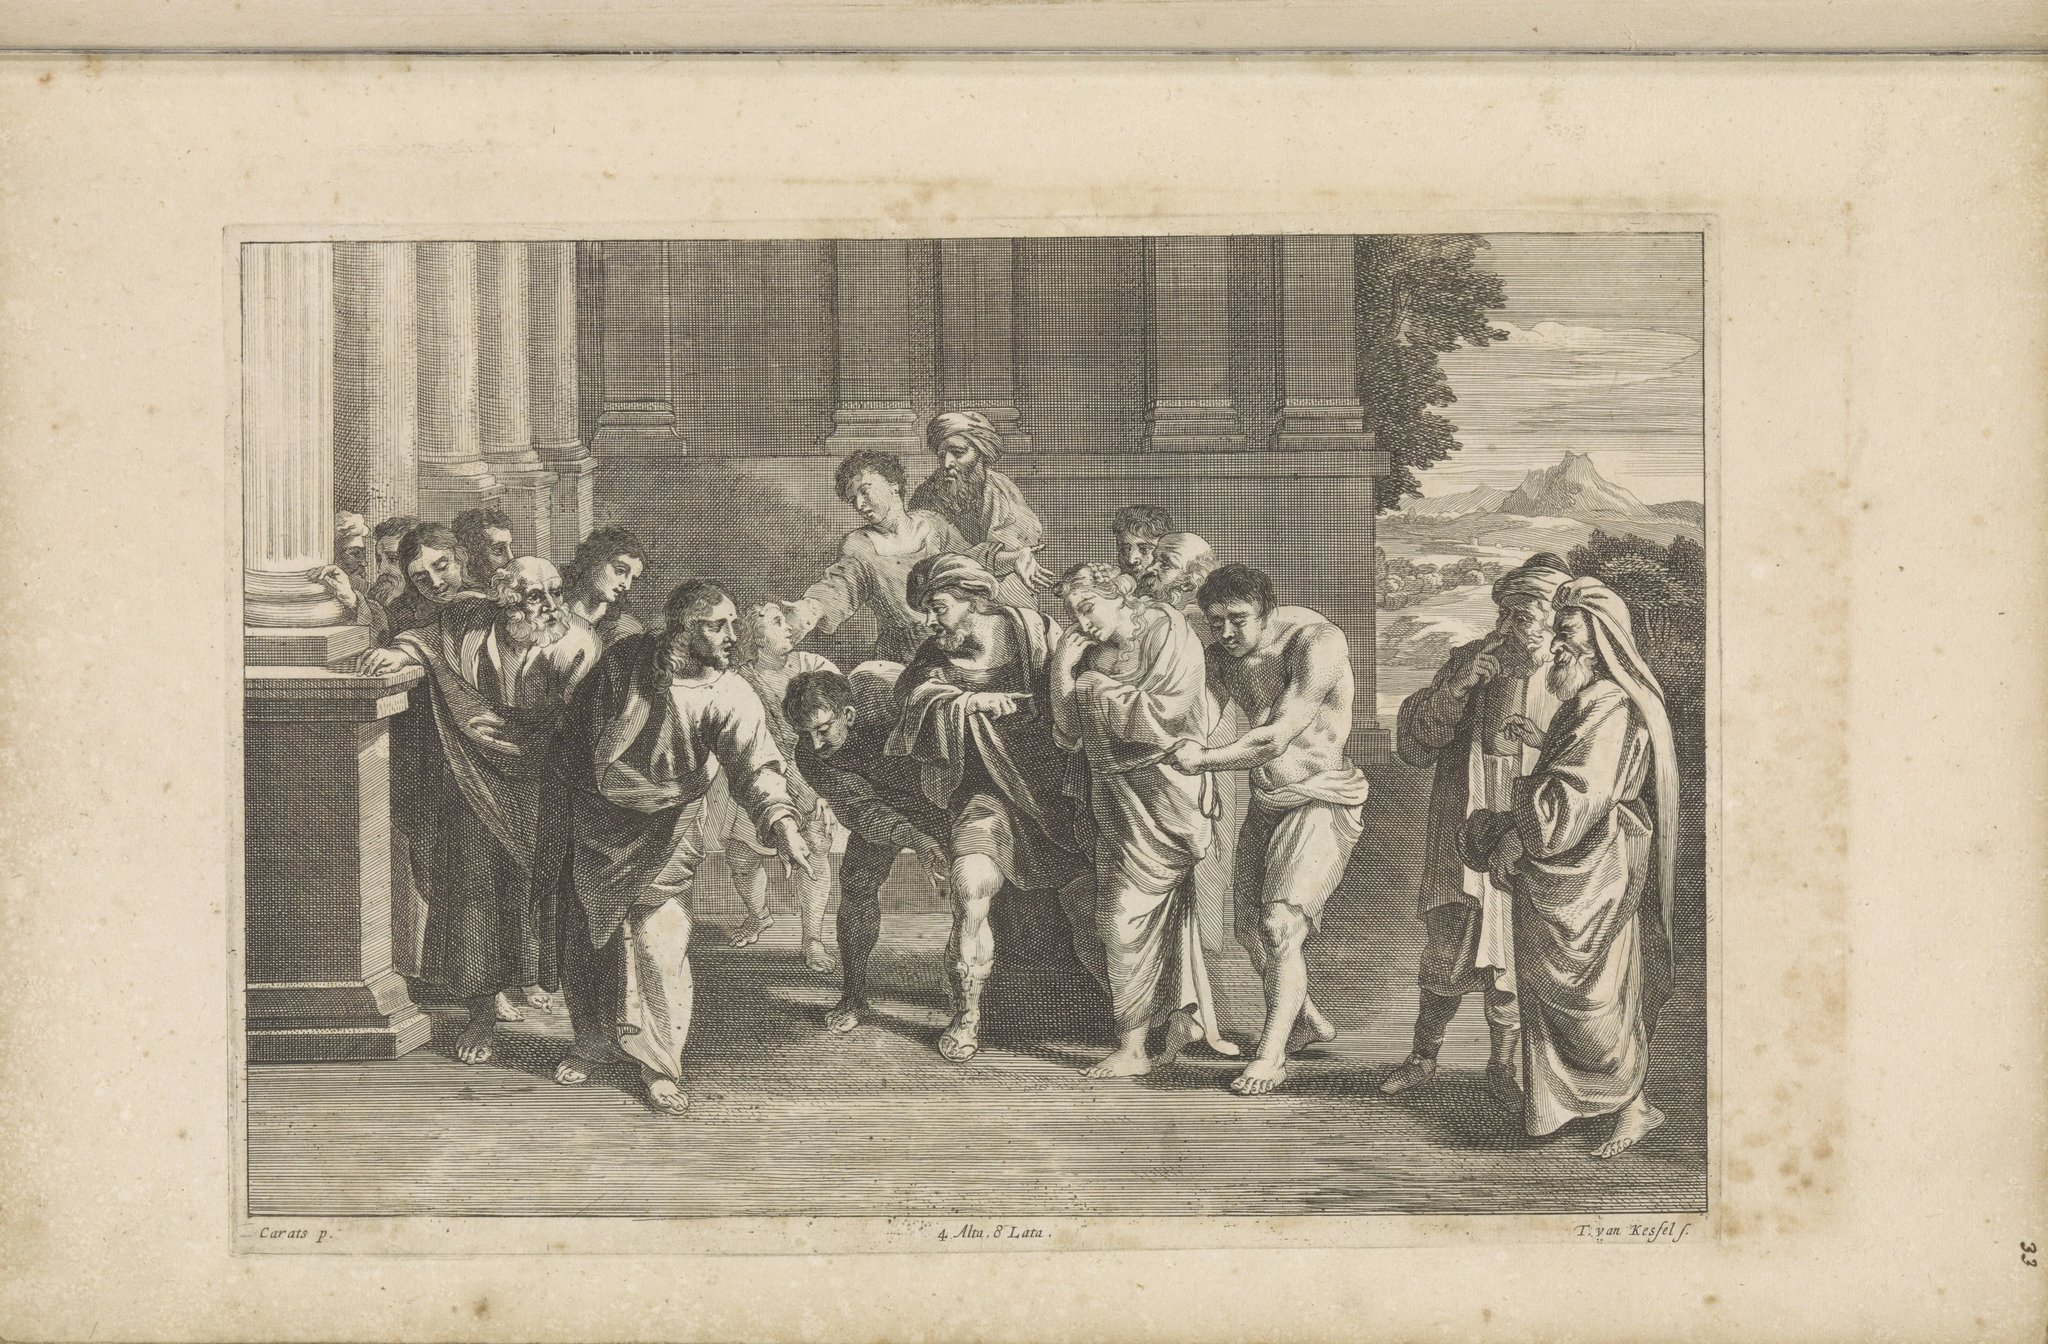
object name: print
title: Christus en de overspelige vrouw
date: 1660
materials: paper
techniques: engraving, etching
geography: antwerp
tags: christ points to or writes on the ground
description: David Teniers heeft waarschijnlijk van alle schilderijen uit de collectie van Leopold Willem van Oostenrijk een olieverfstudie op doek of paneel vervaardigd (zgn. pasticcio), die als voorbeeld voor de prentmakers diende. Het is niet altijd duidelijk of de pasticci door hem zijn gemaakt of door zijn atelier. Niet alle pasticci zijn overgeleverd.